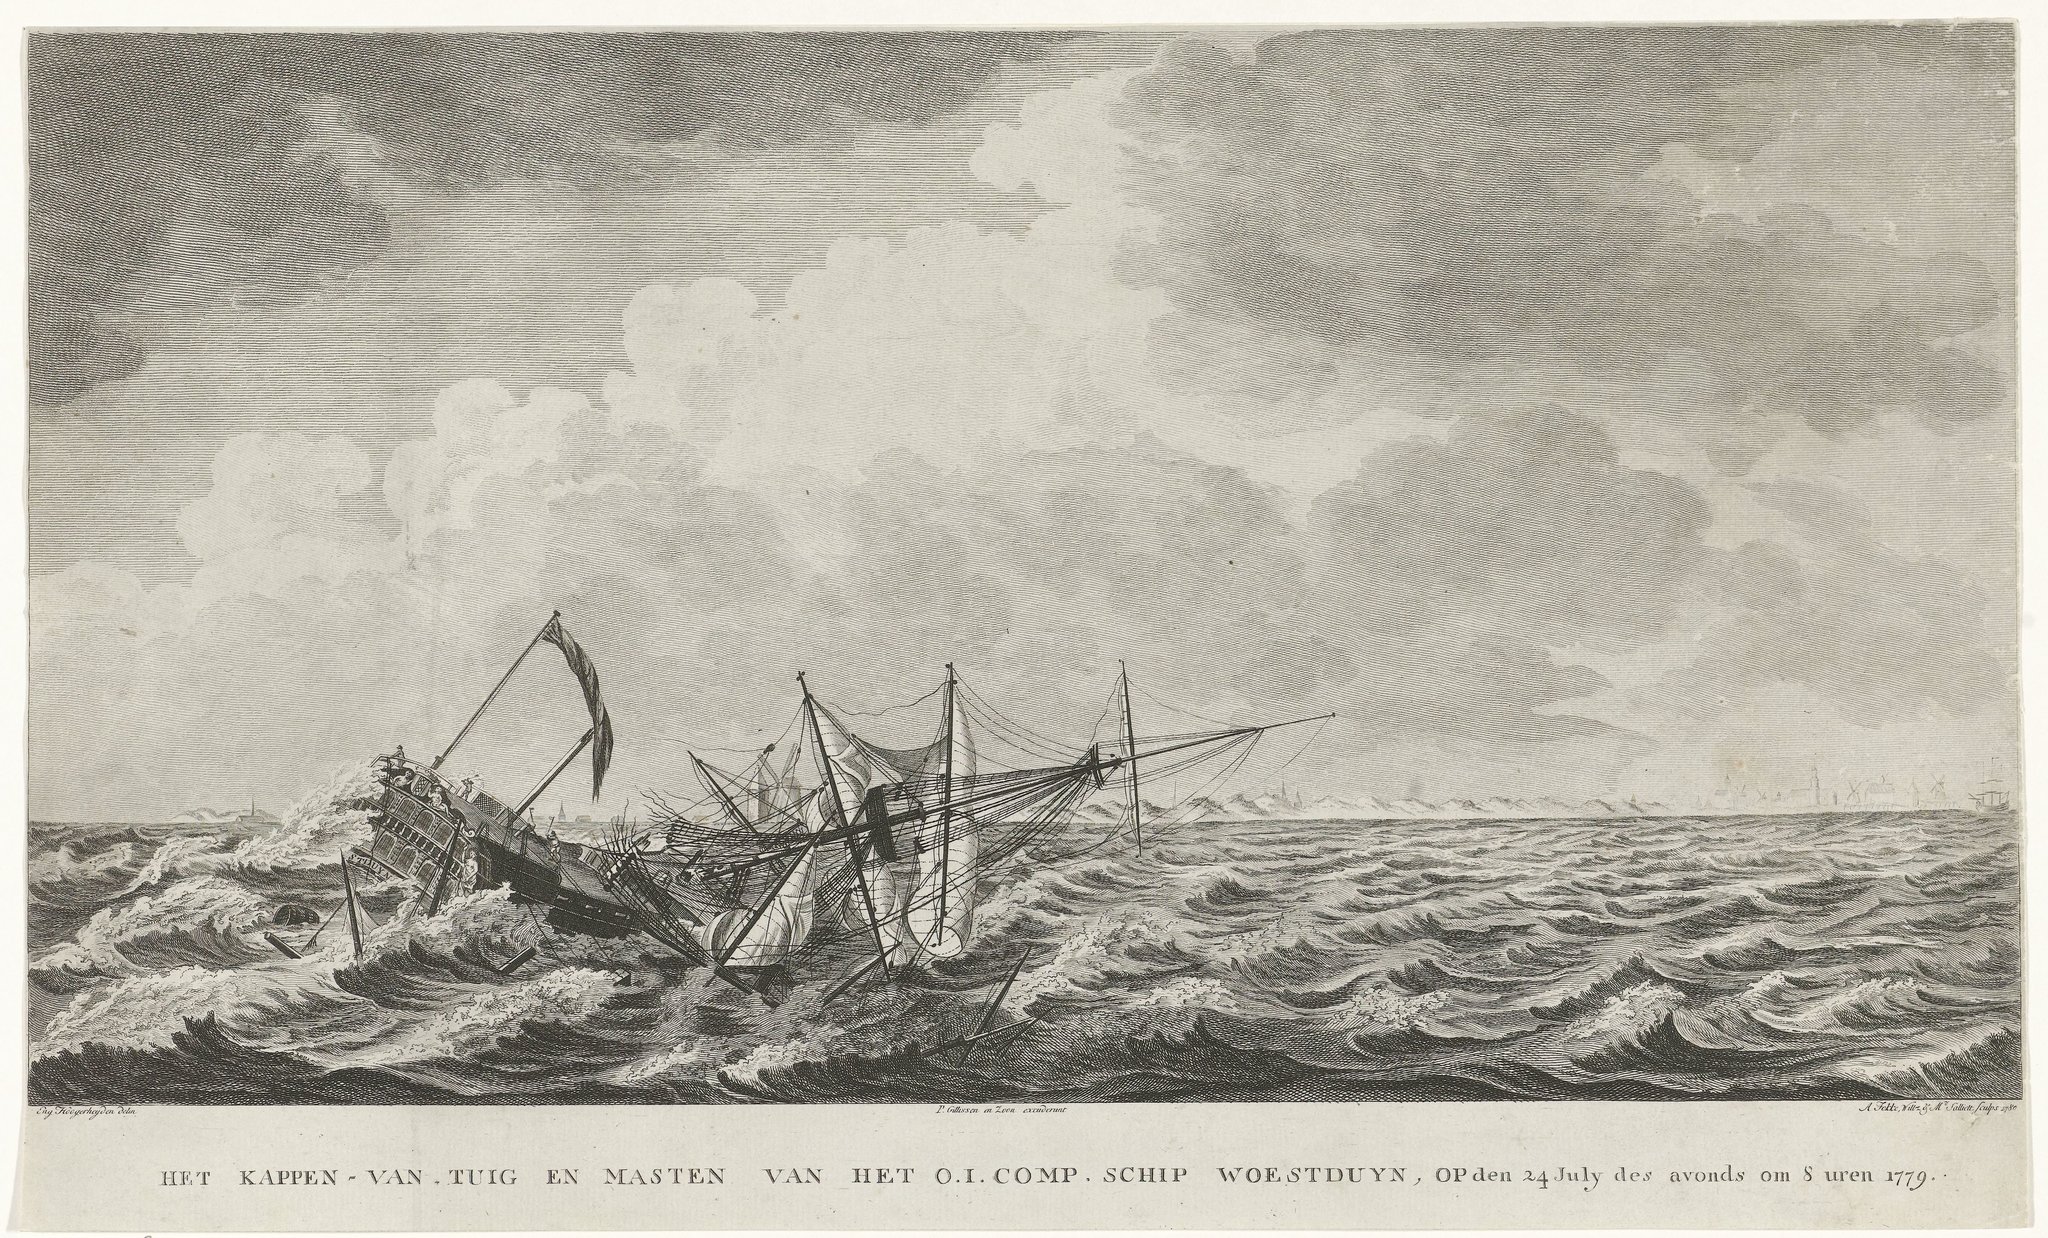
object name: print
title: Het kappen van tuig en masten van het O.I. Comp. Schip Woestduyn, op den 24 July des avonds om 8 uren 1779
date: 1780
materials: paper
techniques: engraving, etching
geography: middelburg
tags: shipwreck, exploration, expedition, voyage of discovery, parts of ship's exterior: mast, flushing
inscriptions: collector's mark: Lugt 2166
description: Het VOC-schip 'Woestduin' van de Kamer Amsterdam is vlak voor terugkeer van zijn vijfde thuisreis uit Batavia op de Noorderassen bij Vlissingen vastgelopen. Op het schip kappen mannen met bijlen de masten. Als teken dat het schip in nood verkeert, is de vlag gedeeltelijk opgerold.